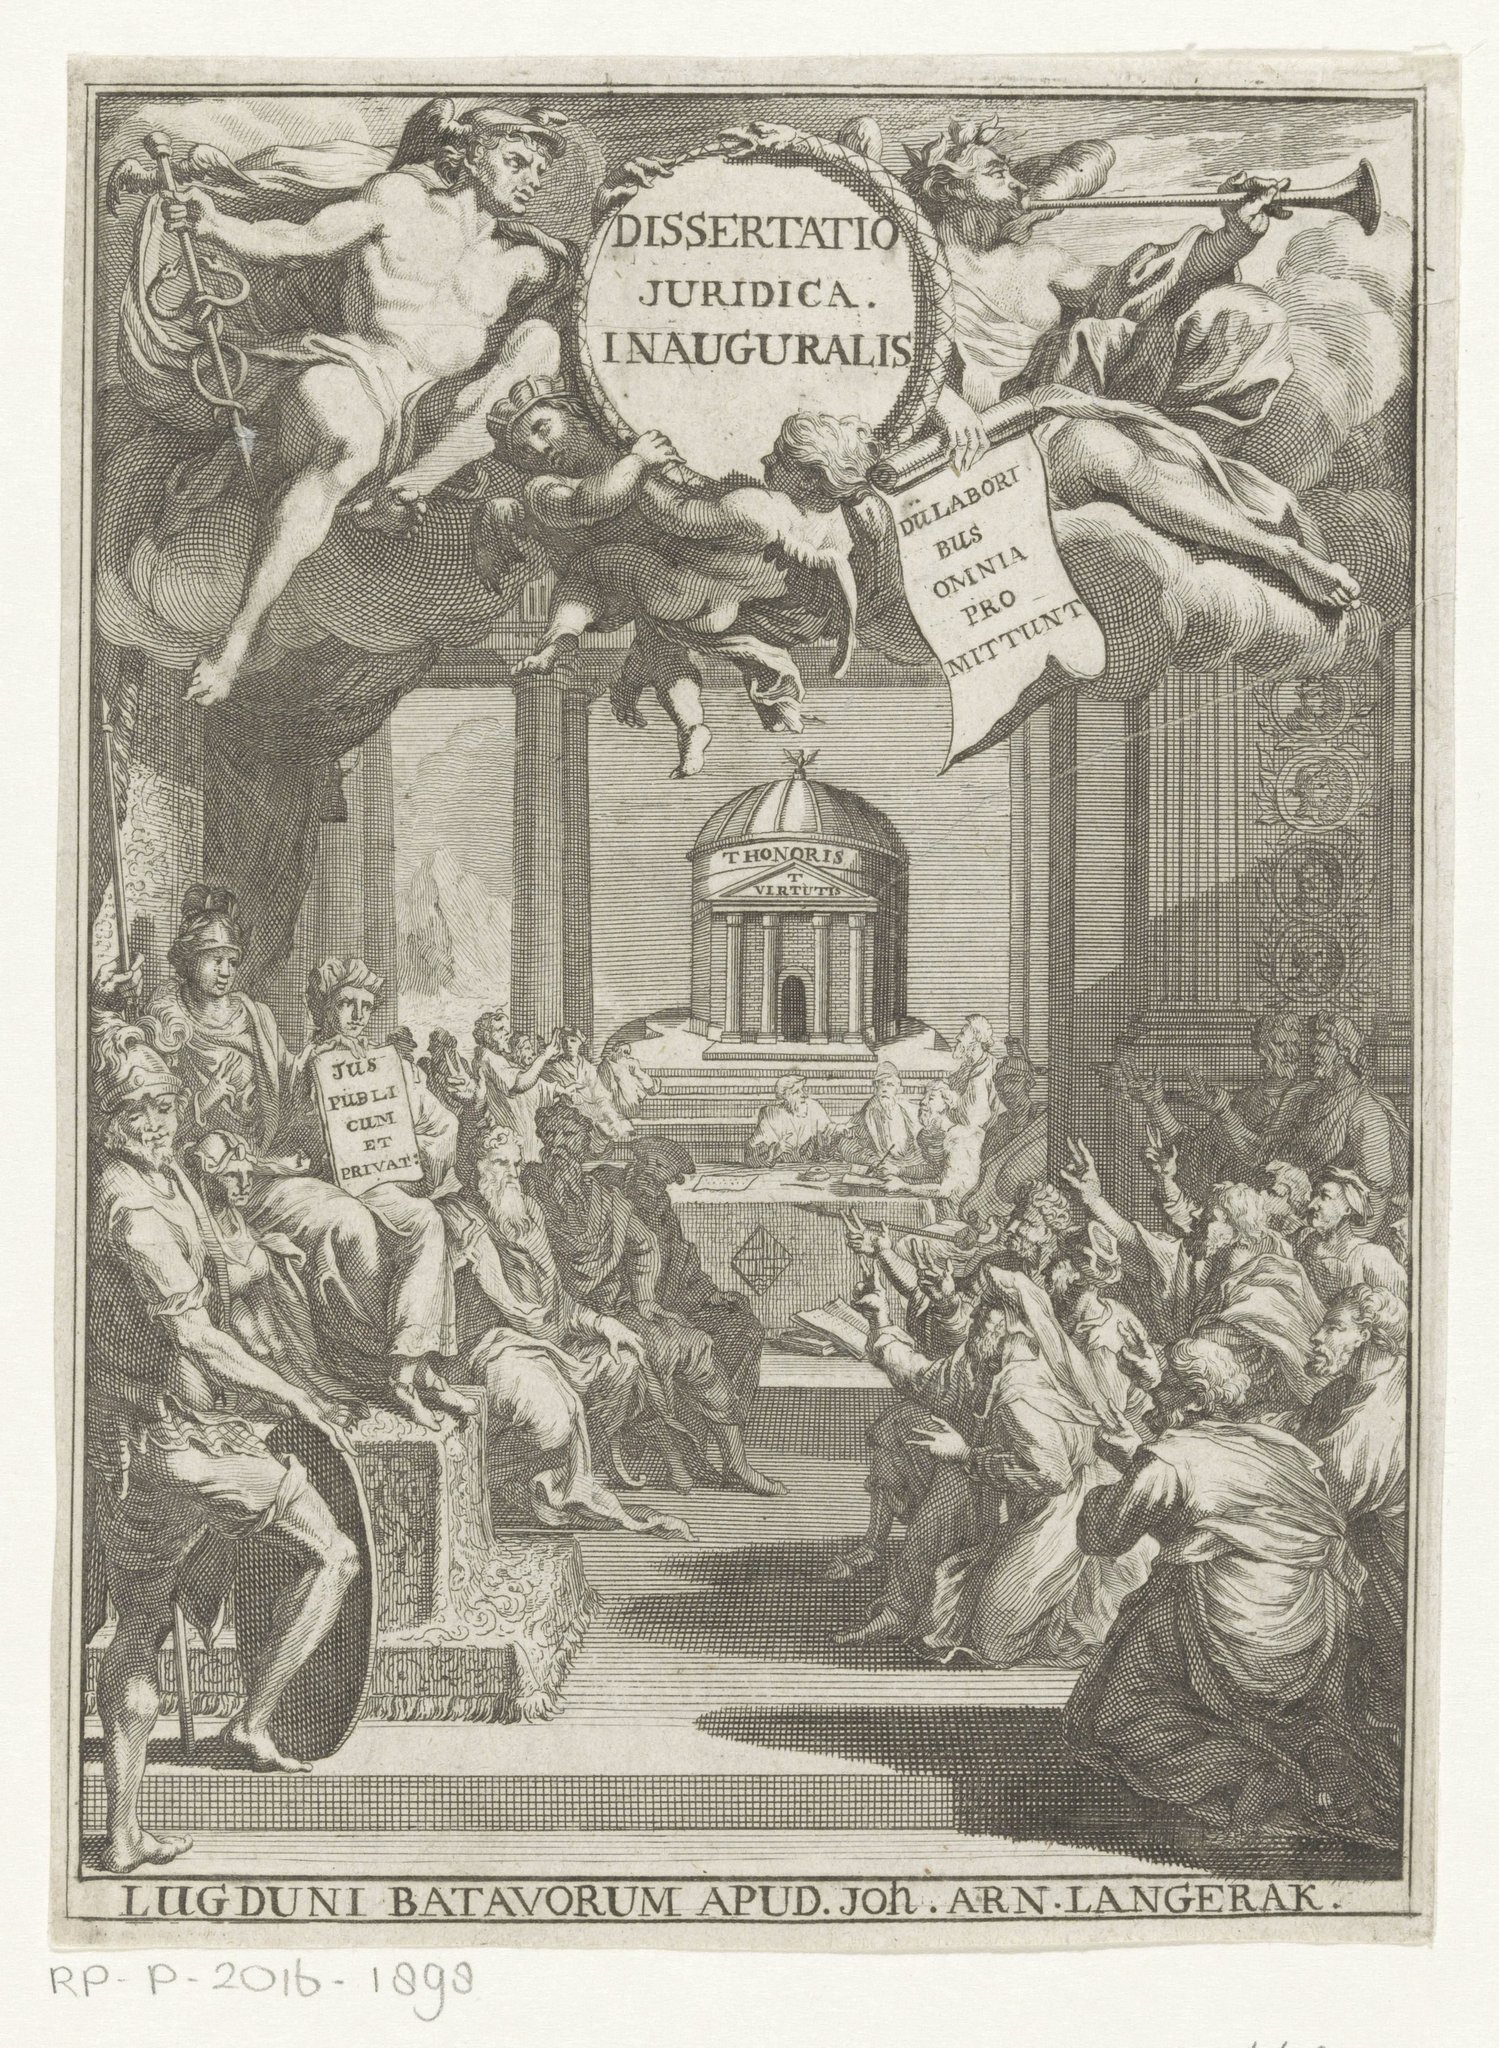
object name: print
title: Dissertatio juridica inauguralis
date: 1710-1750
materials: paper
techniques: engraving, etching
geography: leiden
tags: (story of) minerva (pallas, athena), group of scholars or philosophers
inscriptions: collector's mark: Lugt 2228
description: Links op een troon zit een vrouw, mogelijk Minerva als personificatie van rechtvaardigheid, met een tablet met het devies Jus publicum et privat[um]. Links van haar staat een soldaat, rechts zitten drie geleerden. Voor haar zit een groep mannen, mogelijk ook geleerden, knielend en allen met het spreekgebaar. In de achtergrond zitten geleerden aan tafel voor een tempel van Honos en Virtus. Aan de bovenzijde flankeren Mercurius met caduceus en Fama met bazuin een medaillon met titel gedragen door twee putto. In haar hand houdt Fama een papierrol met tekst Dii laboribus omnia promittunt.